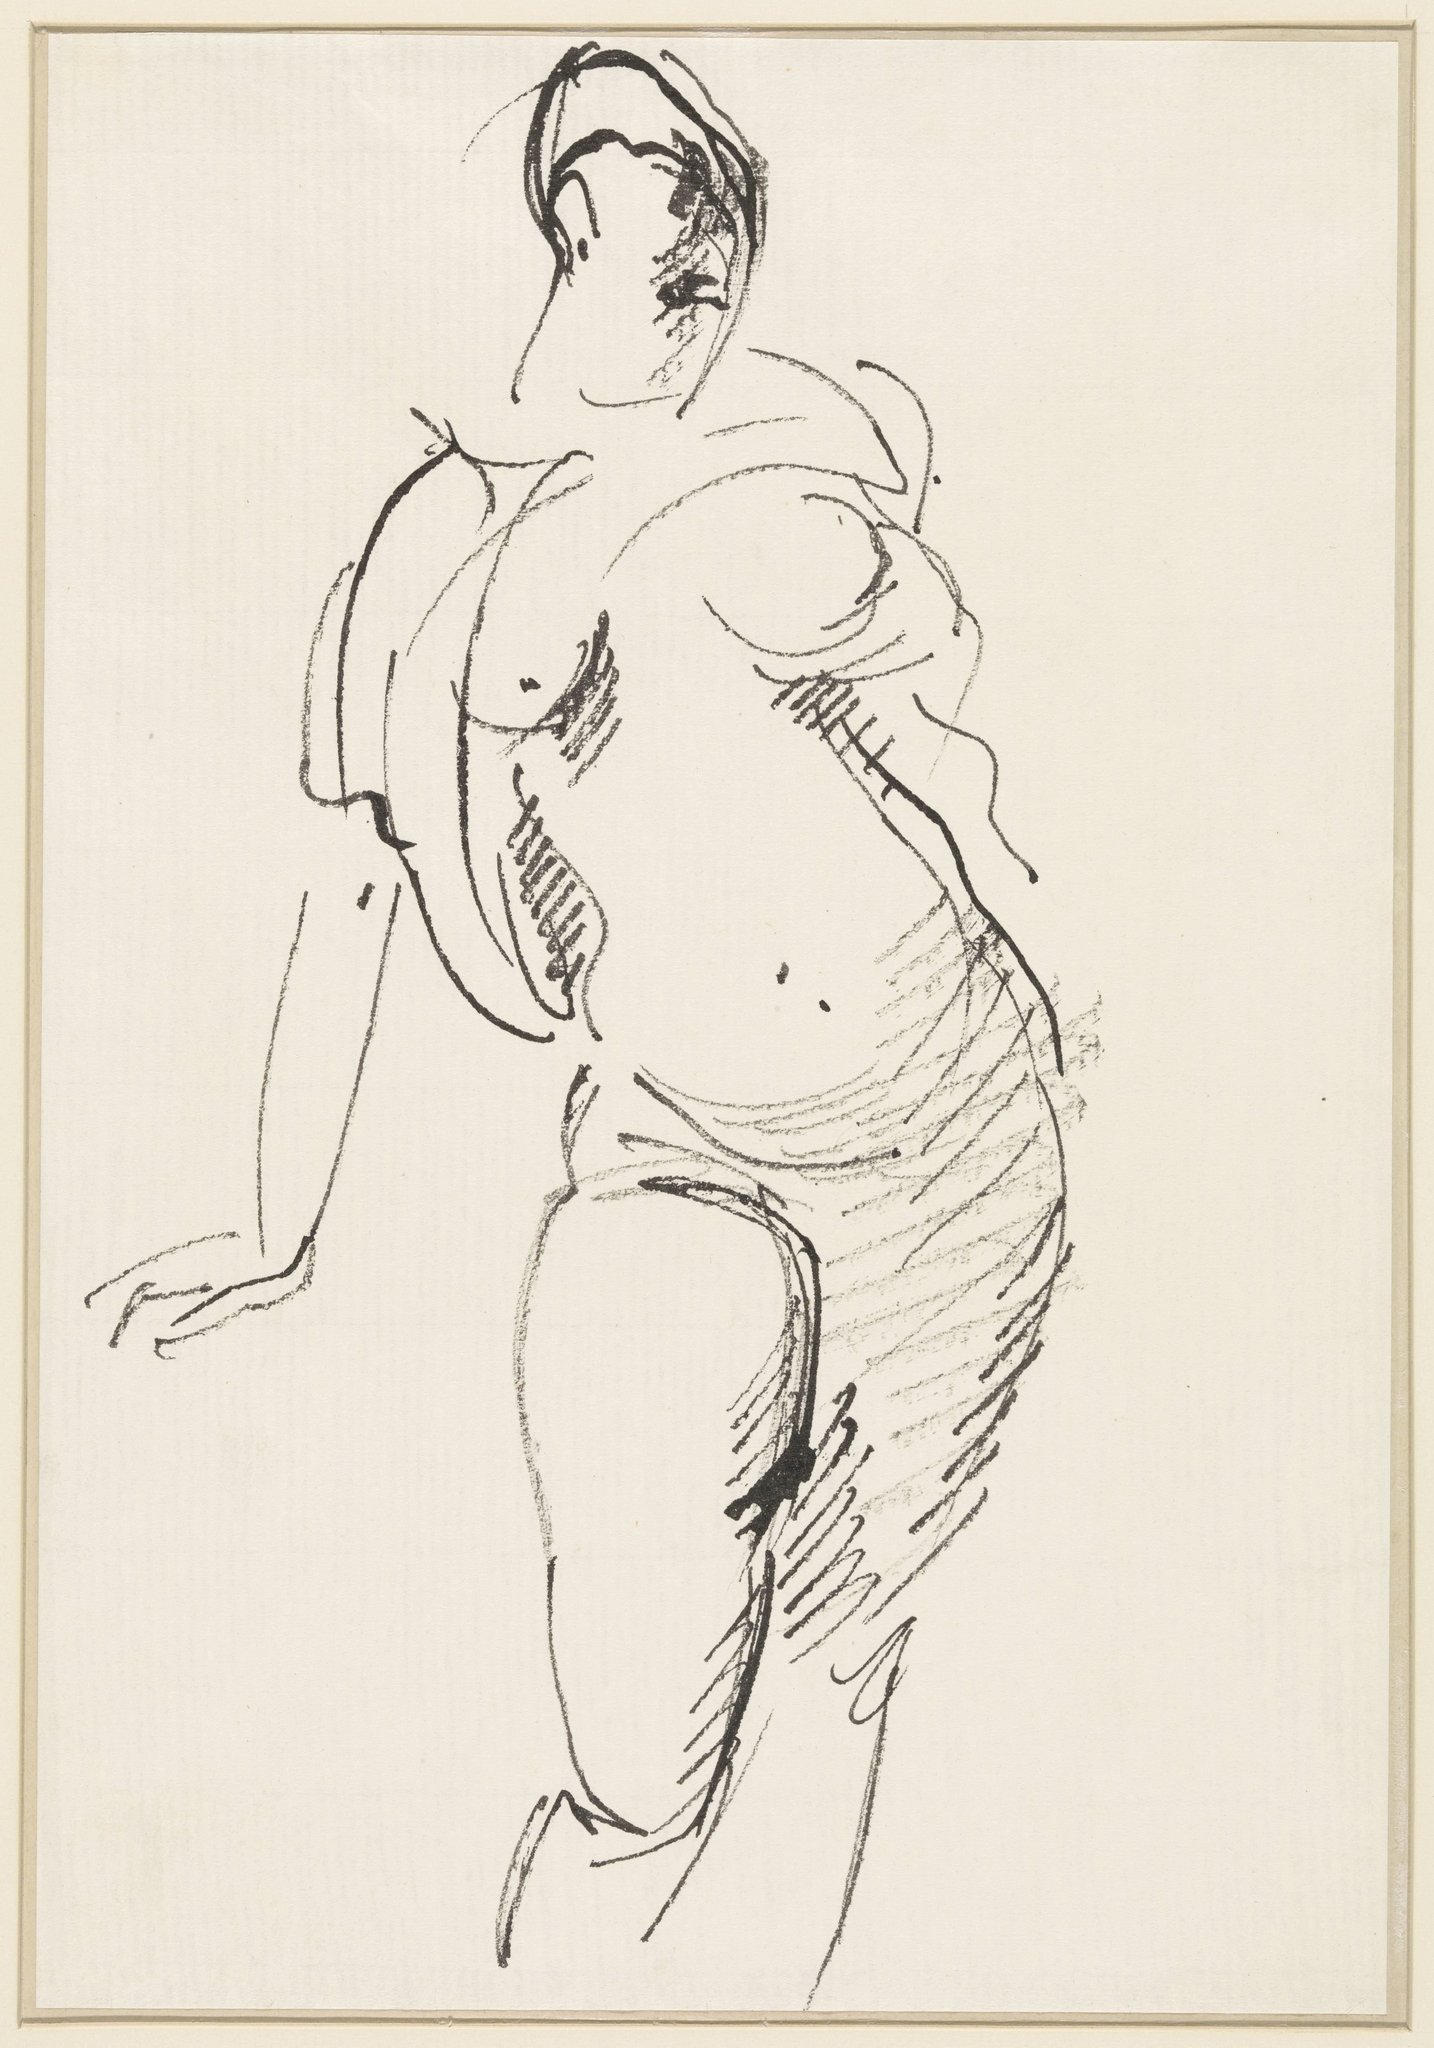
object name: drawing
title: Standing Female Nude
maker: rik wouters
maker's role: draughtsman, print maker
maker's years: 1882-1916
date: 1892-1916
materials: ink, paper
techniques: pen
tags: standing figure - aa - female human figure